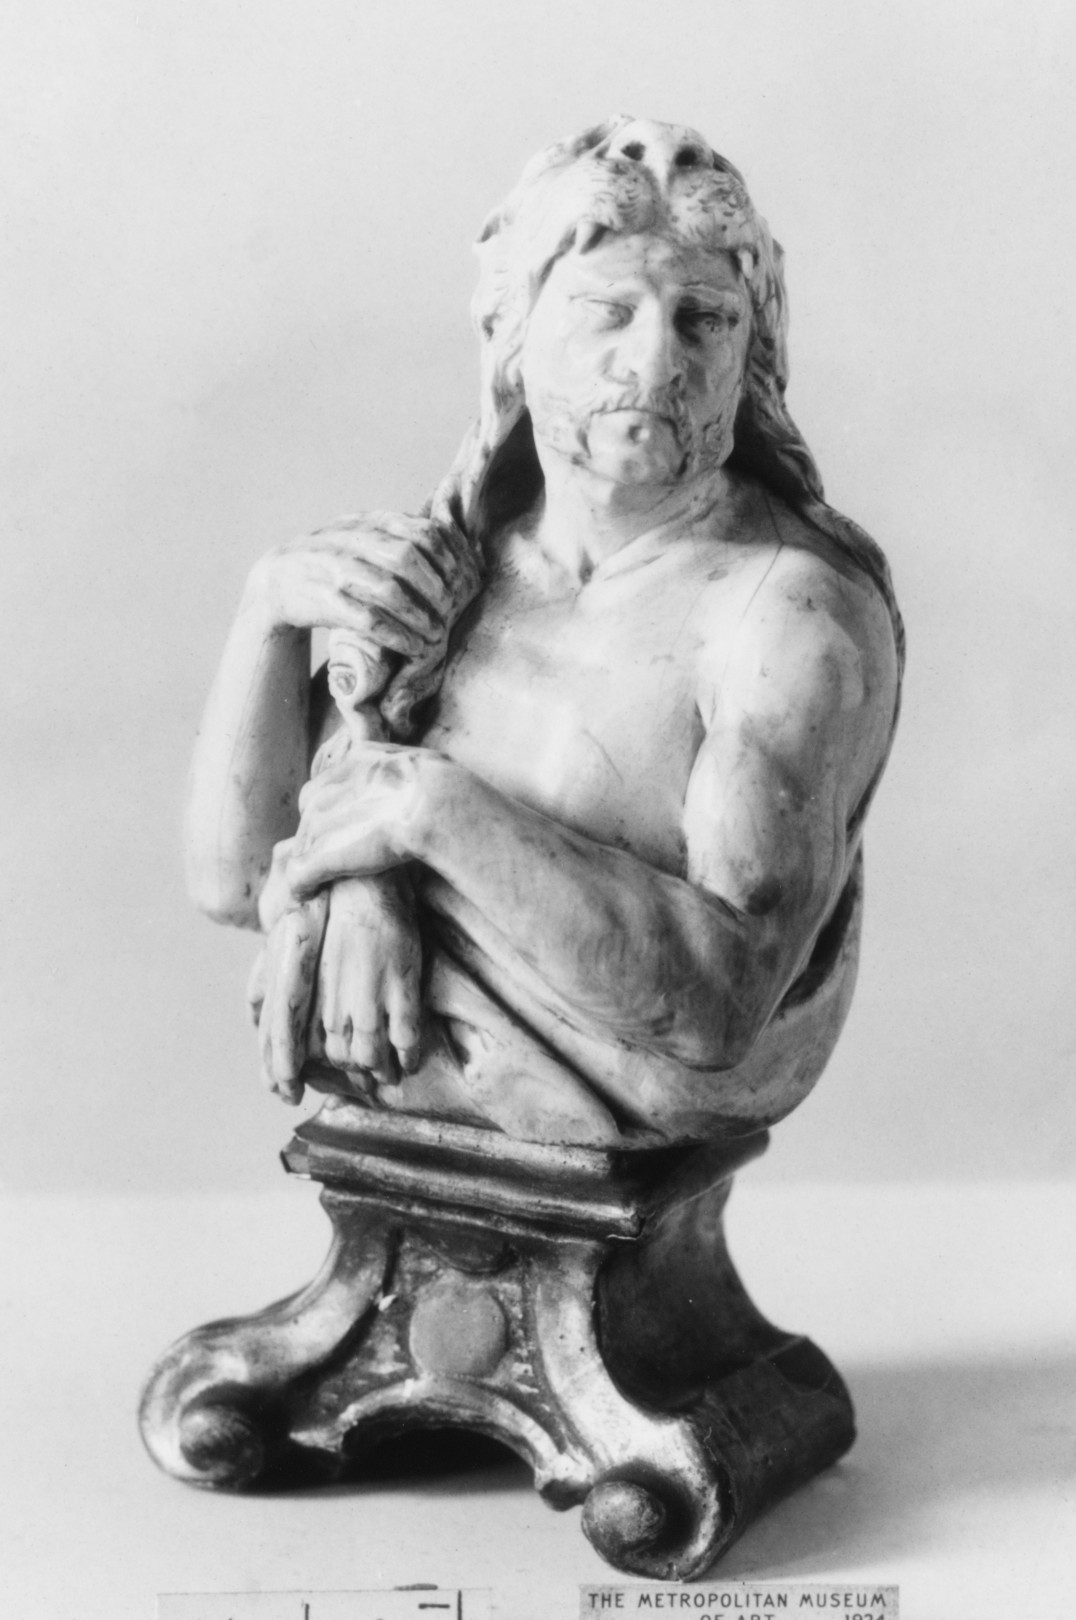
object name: bust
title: Hercules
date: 1601-1650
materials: ivory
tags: portraits,hercules